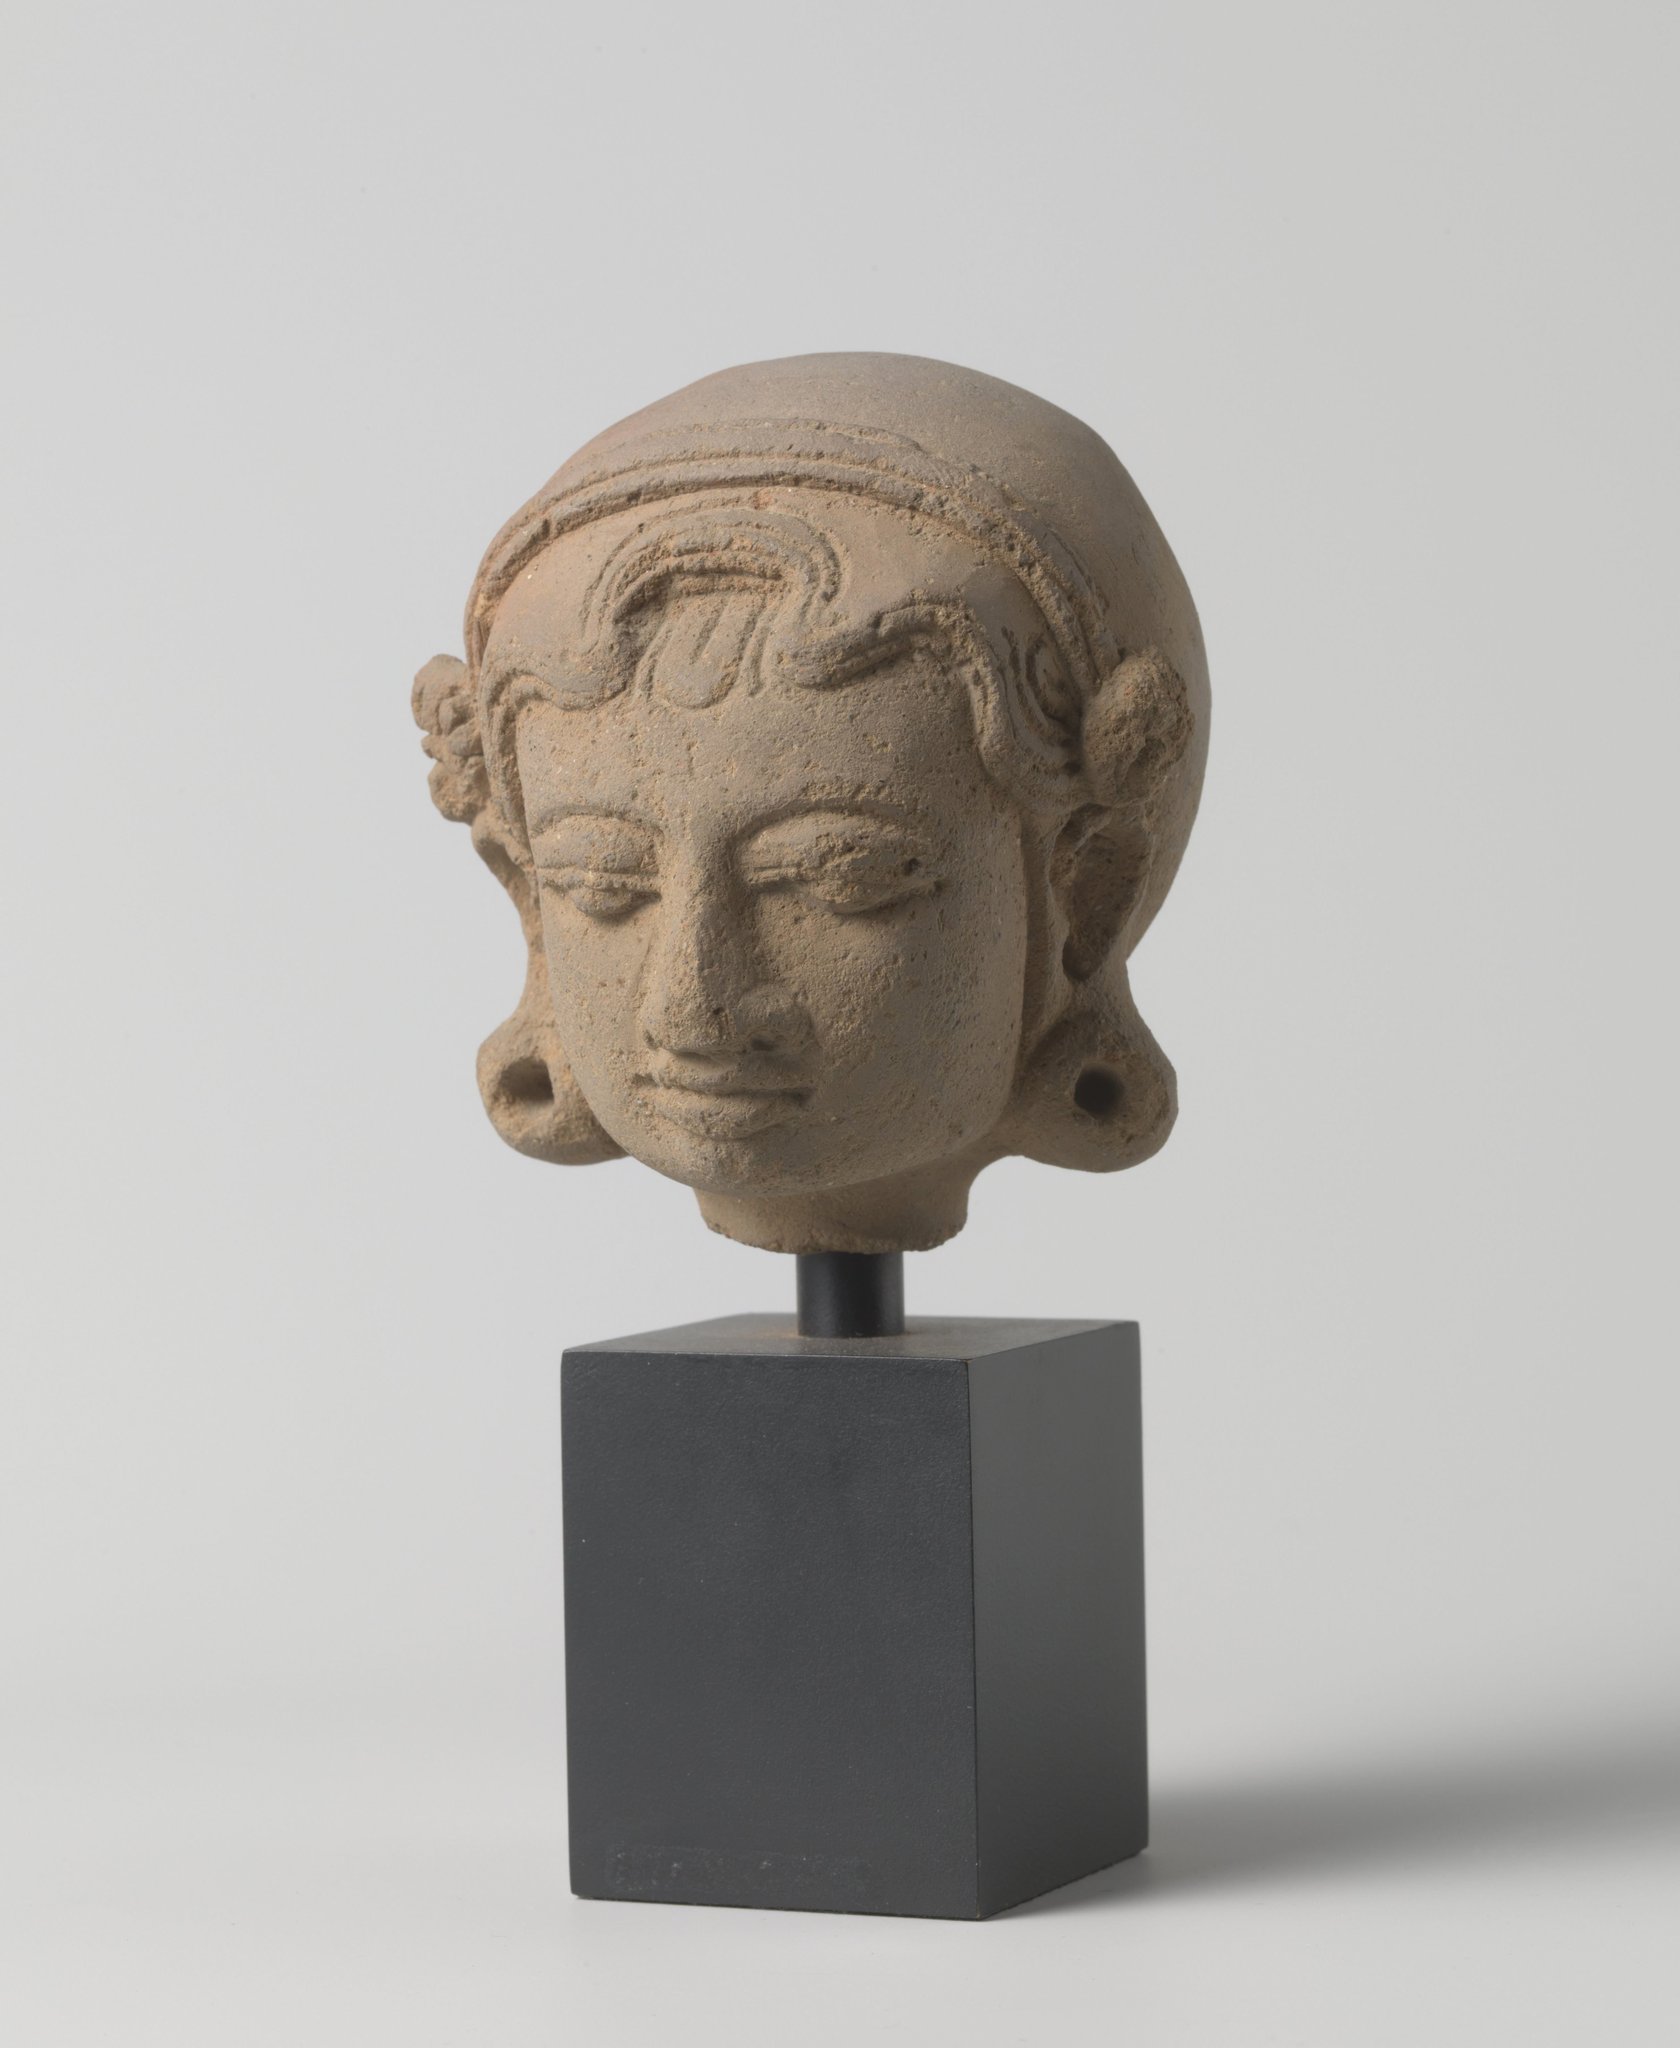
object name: sculpture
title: Vrouwenkop met hoofdkap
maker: Anonymous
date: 1300-1500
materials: terracotta, wood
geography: indonesia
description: Fragment (hoofd) van een vrouw met nauw op de schedel aansluitende hoofdkap. Op sokkel.